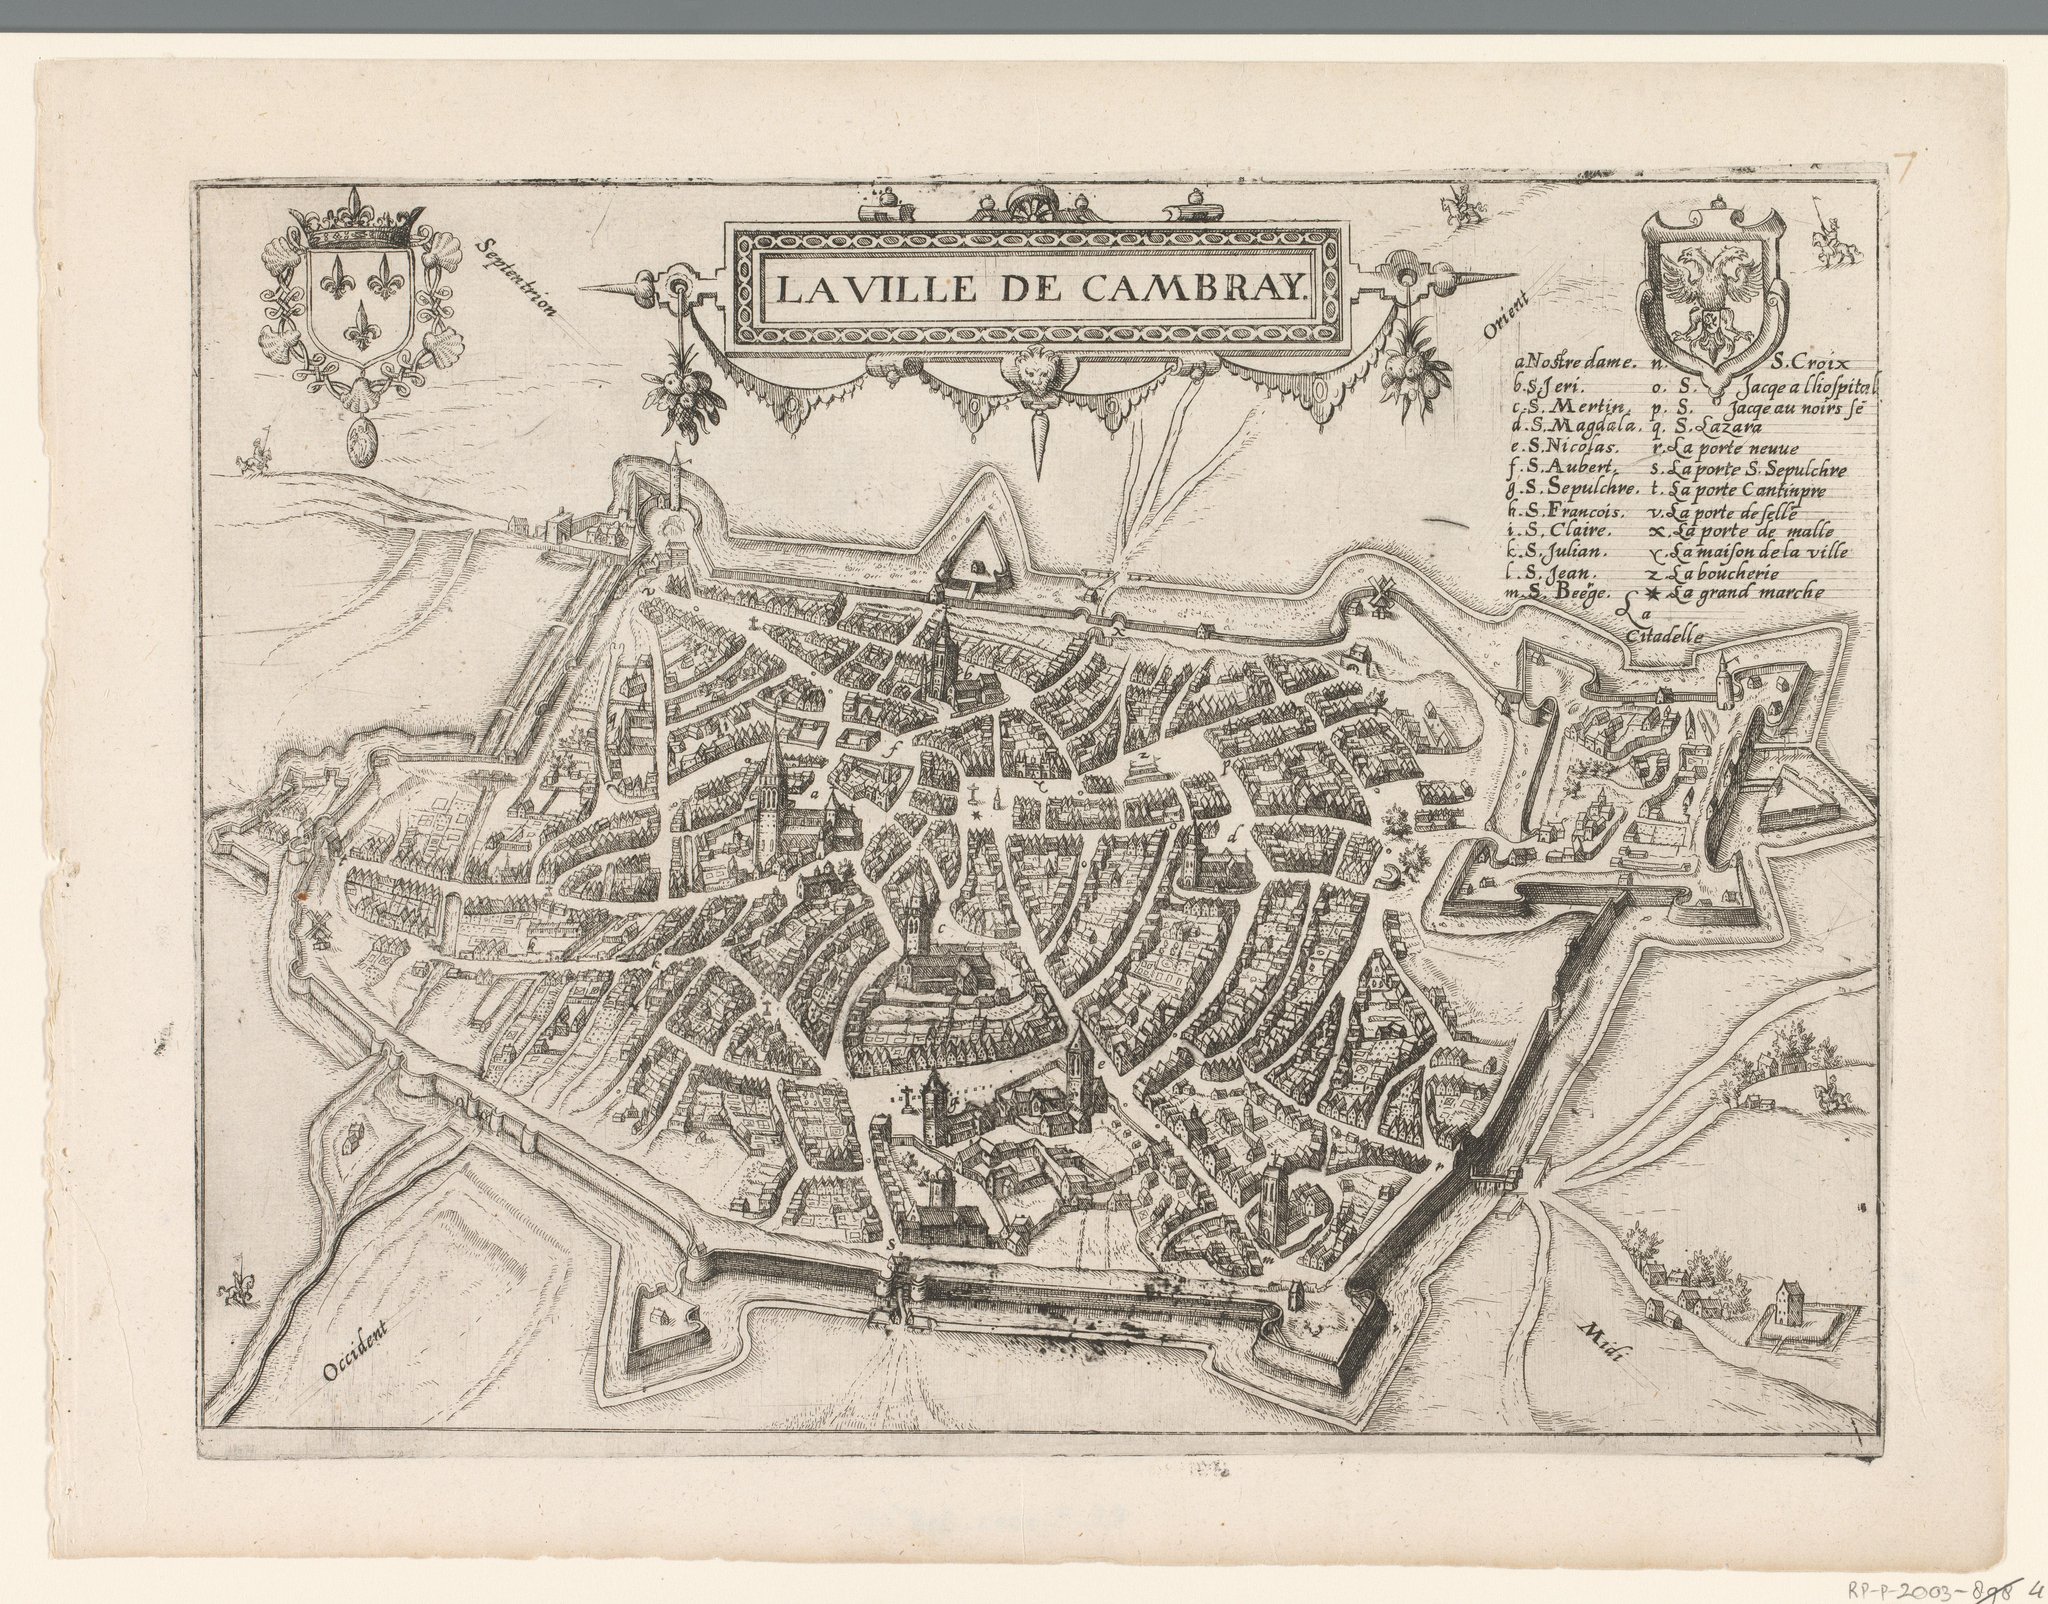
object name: area plan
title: La ville de Cambray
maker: Anonymous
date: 1607-1609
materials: paper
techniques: etching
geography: southern netherlands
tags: maps of cities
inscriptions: number: ‘7’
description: Plattegrond van de stad Cambrai, Kamerijk. Links boven een wapen met drie Franse lelies, rechtsboven het stadswapen en de legenda a-z en *. Onderdeel van de verzameling kaarten genomen uit een latere editie van: Descrittione di tutti i Paesi Bassi van Lodovico Guicciardini.